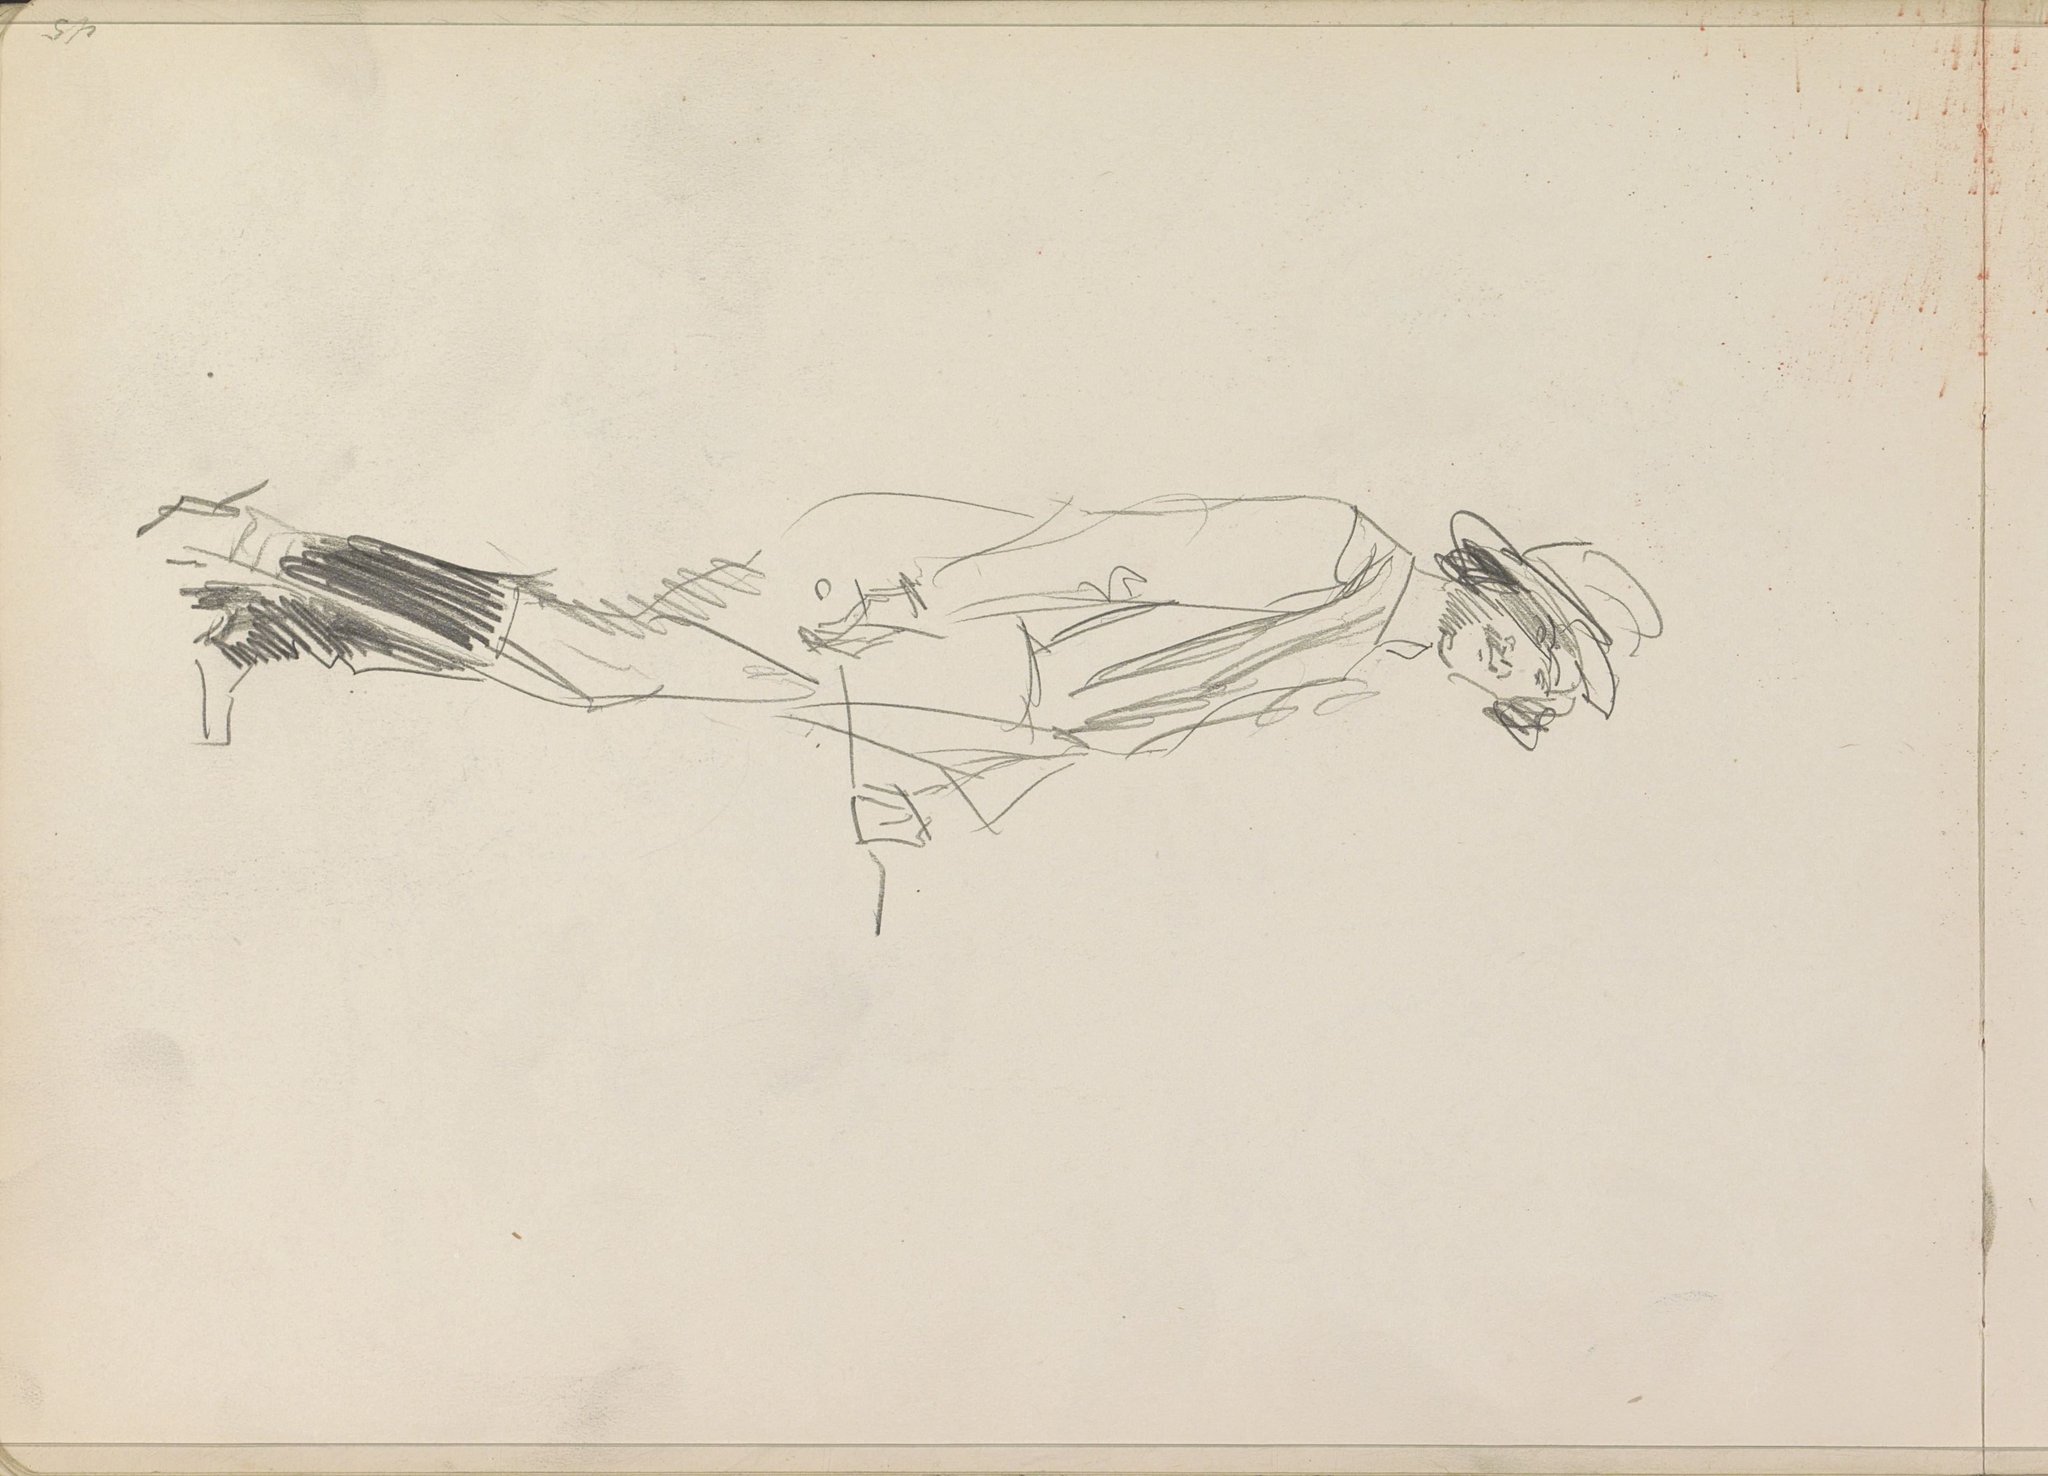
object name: sketchbook leaf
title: Staande figuur met hoed, in profiel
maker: isaac israels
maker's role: draughtsman, painter, print maker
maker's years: 1865-1934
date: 1915-1934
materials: paper, pencil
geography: the hague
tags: standing figure (+ sideview, profile)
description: Blad 22 verso uit schetsboek VI met 33 bladen.